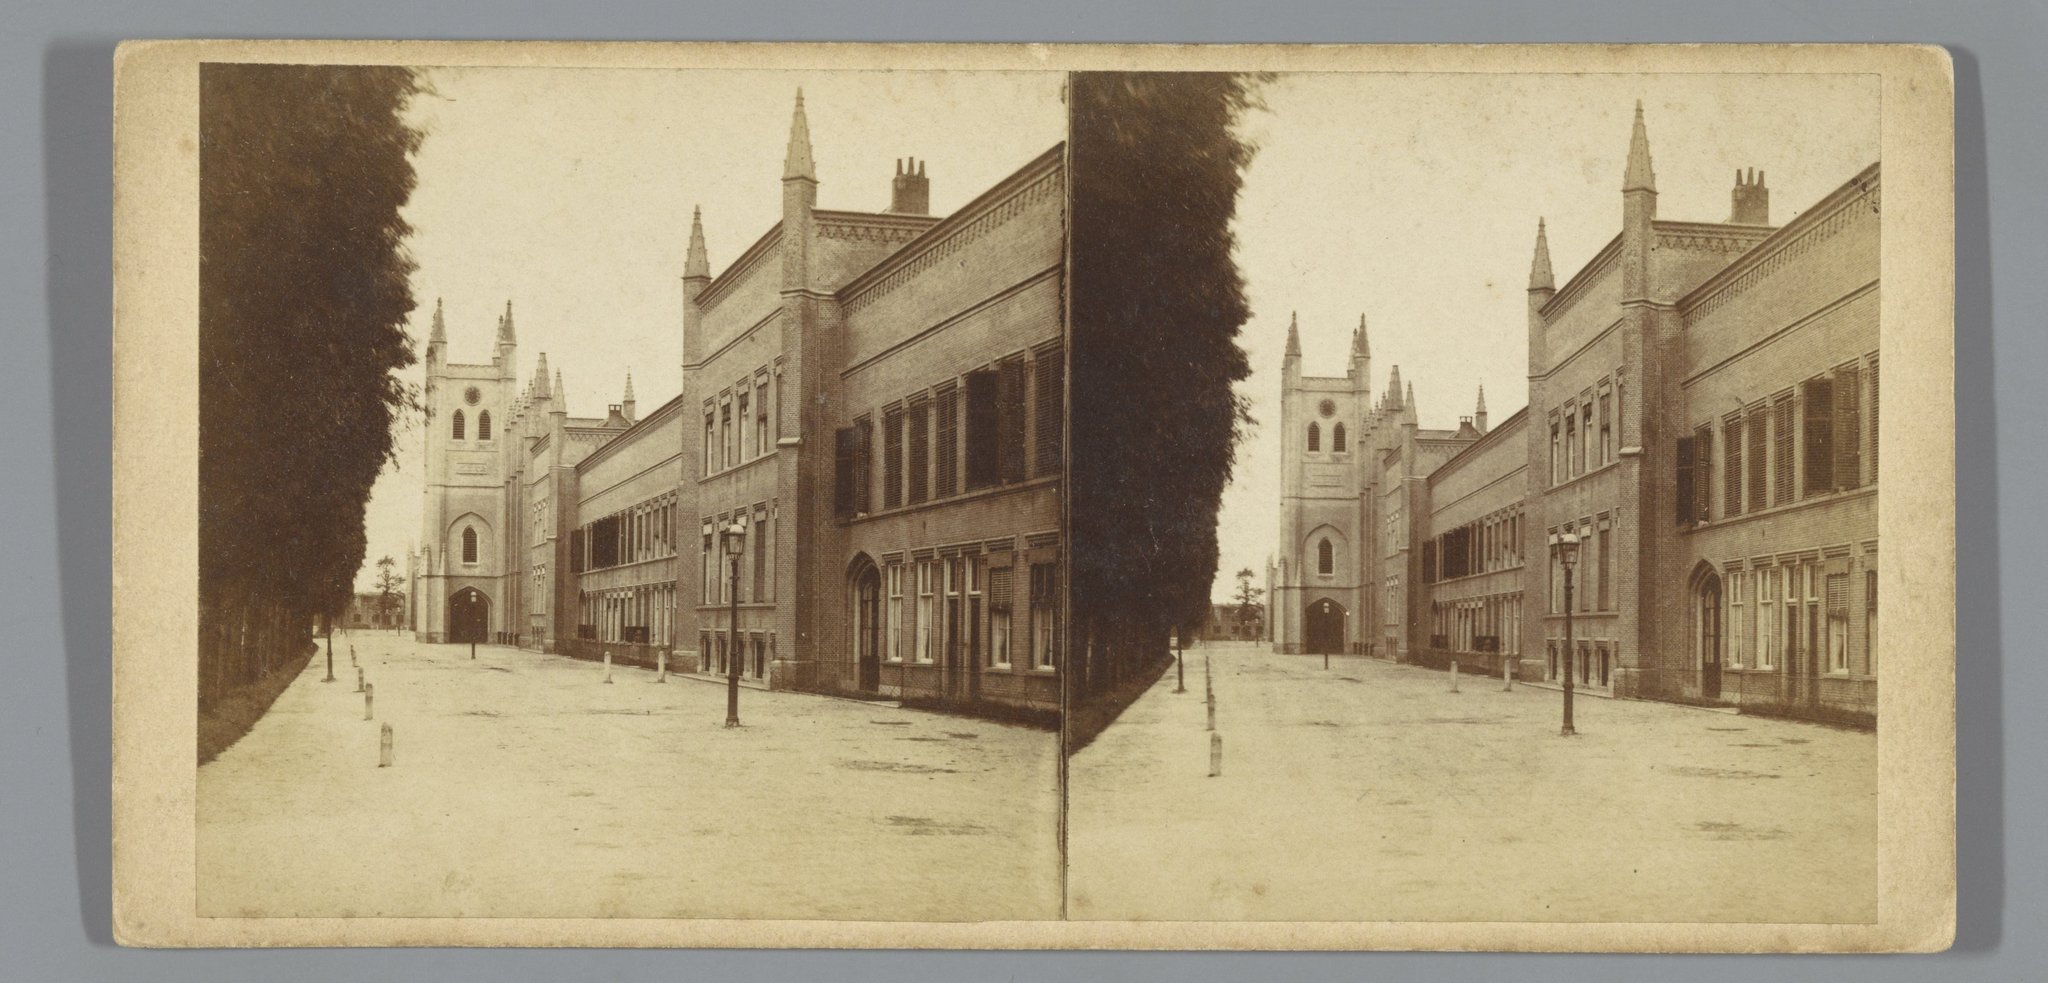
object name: stereograph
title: Willemskerk in Den Haag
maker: pieter oosterhuis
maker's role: draughtsman, print maker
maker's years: 1816-1885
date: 1859-1865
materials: cardboard, paper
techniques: albumen print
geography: the hague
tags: church (exterior)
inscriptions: inscription: ‘f. 4.’, number: ‘No 9’, number: ‘90’